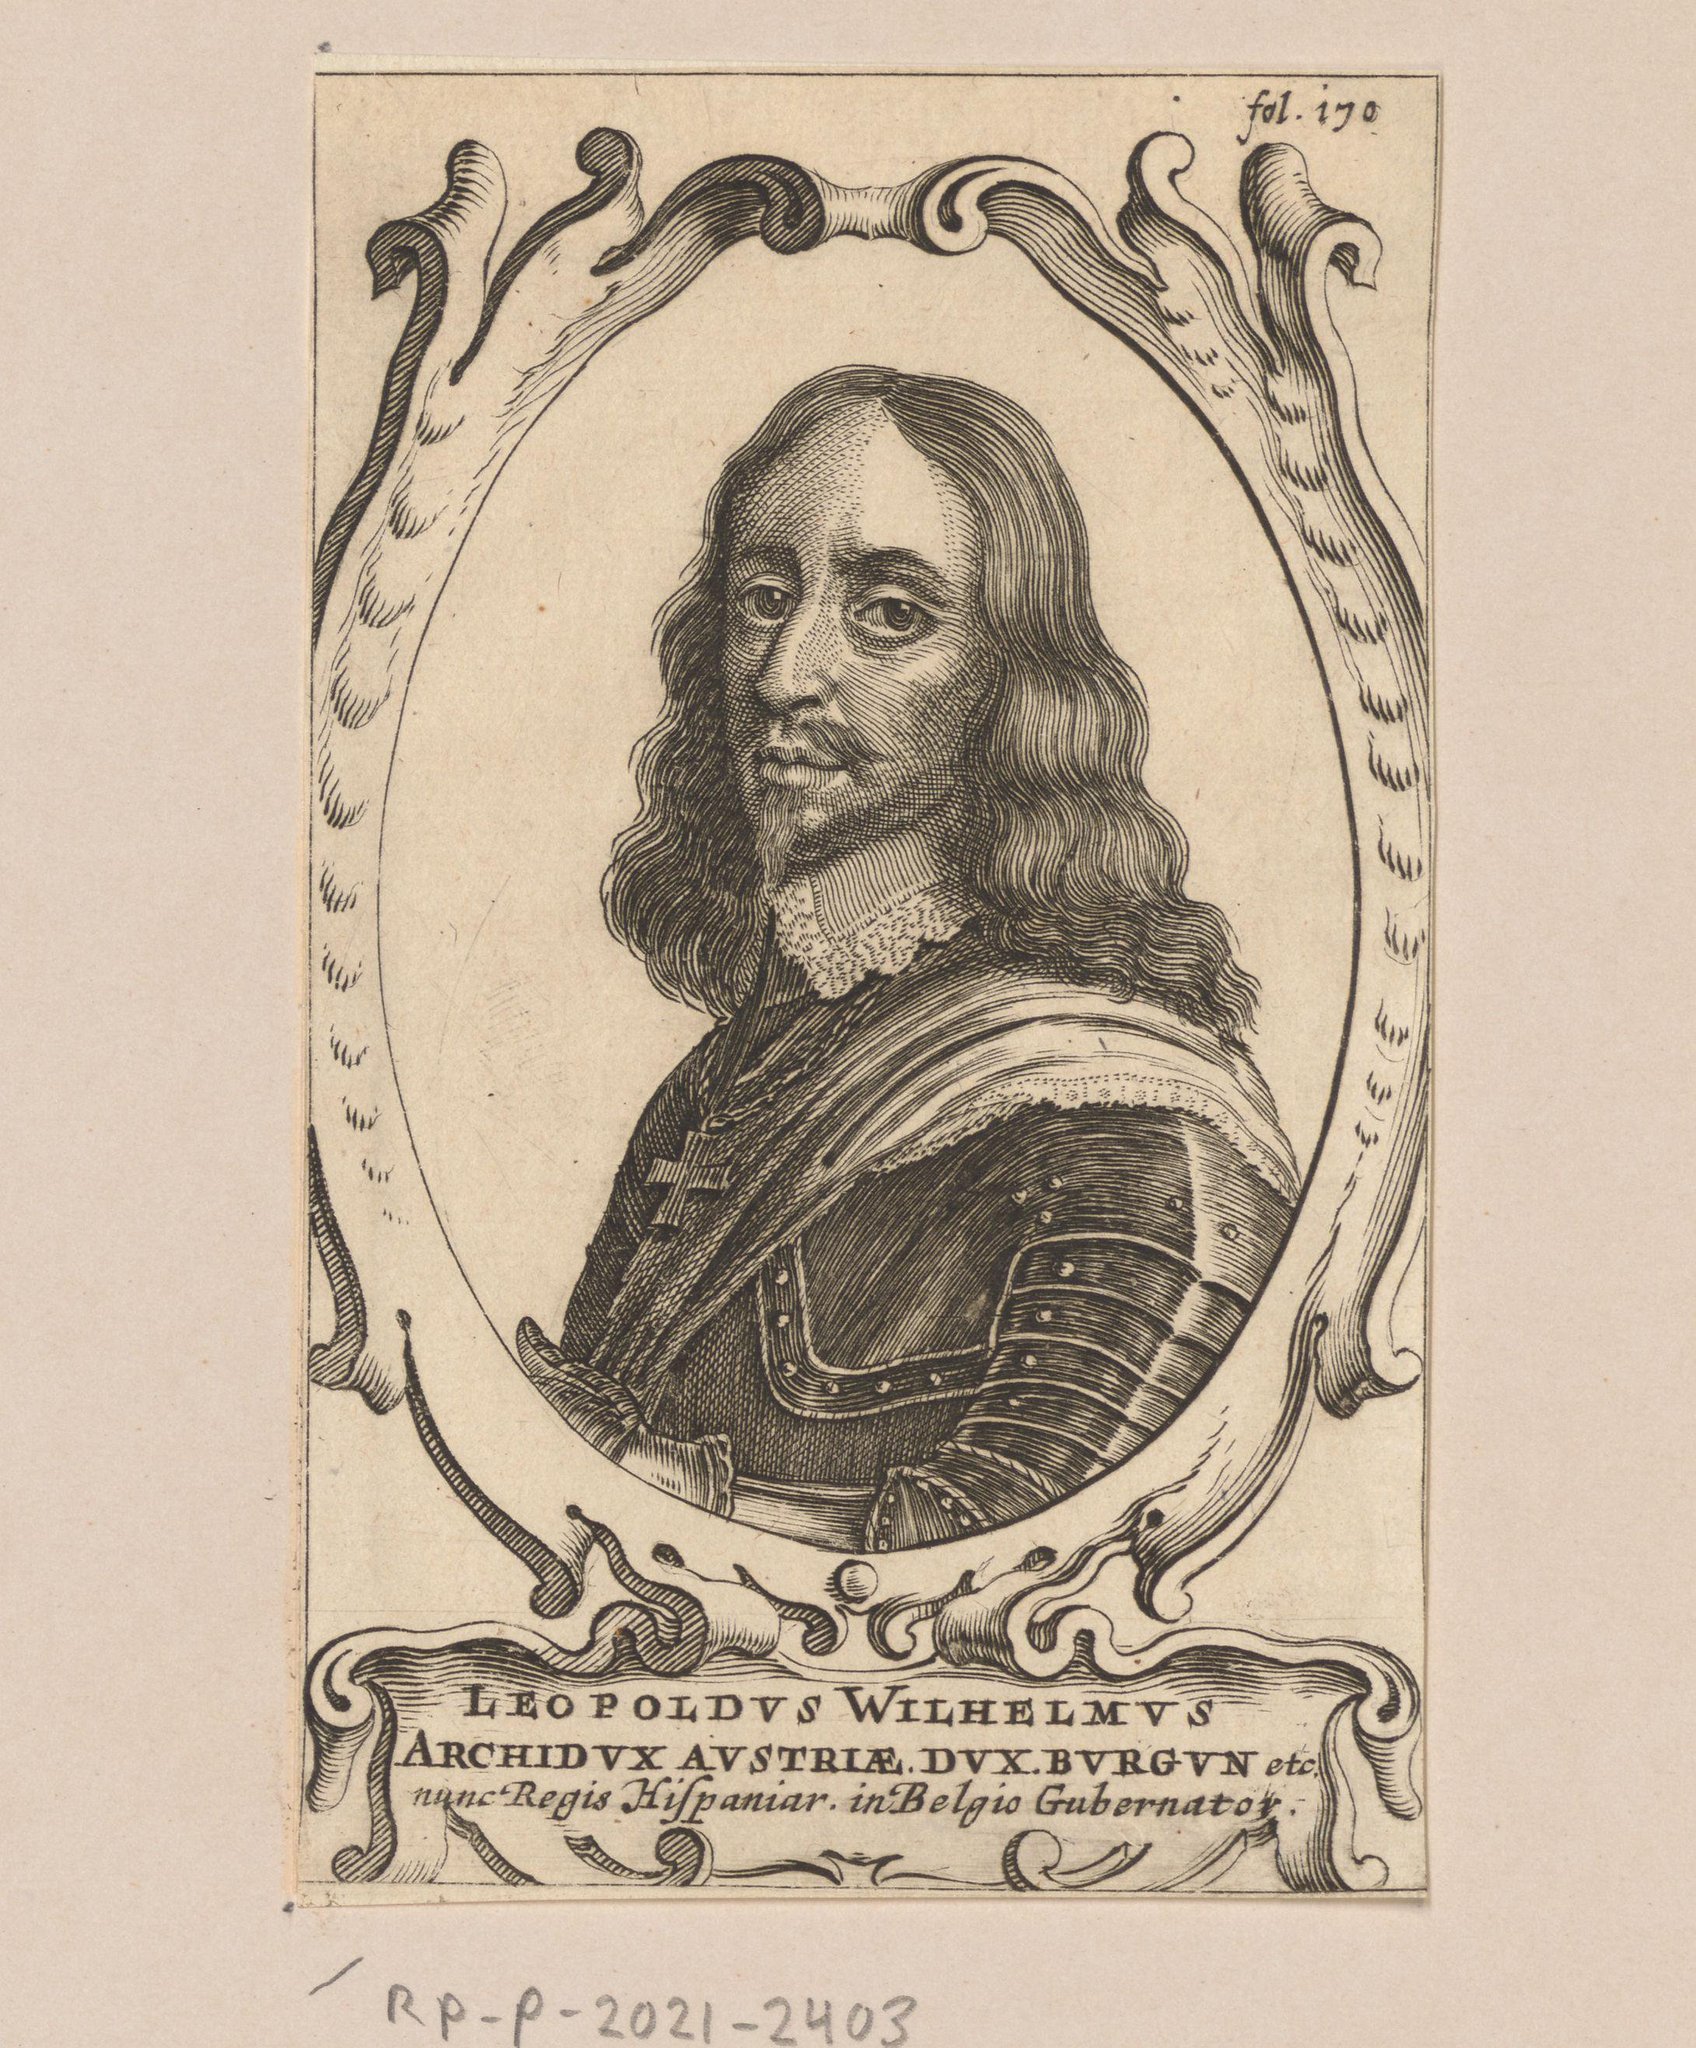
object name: print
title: Portret van Leopold Willem van Oostenrijk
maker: Anonymous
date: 1656-1666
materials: paper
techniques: engraving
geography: northern netherlands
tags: leopold willem van oostenrijk (landvoogd der zuidelijke nederlanden), rocaille ornament, armour, historical persons, governor, etc. of province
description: Prent waarschijnlijk uit: Brachelius, Johannes Adolphus. Historia nostri temporis, dat is geschiedenis onses tijts (…). Rotterdam: Andries van Hoogenhuysen, 1656. Prent ook gebruikt in de 1659- en 1666-editie.